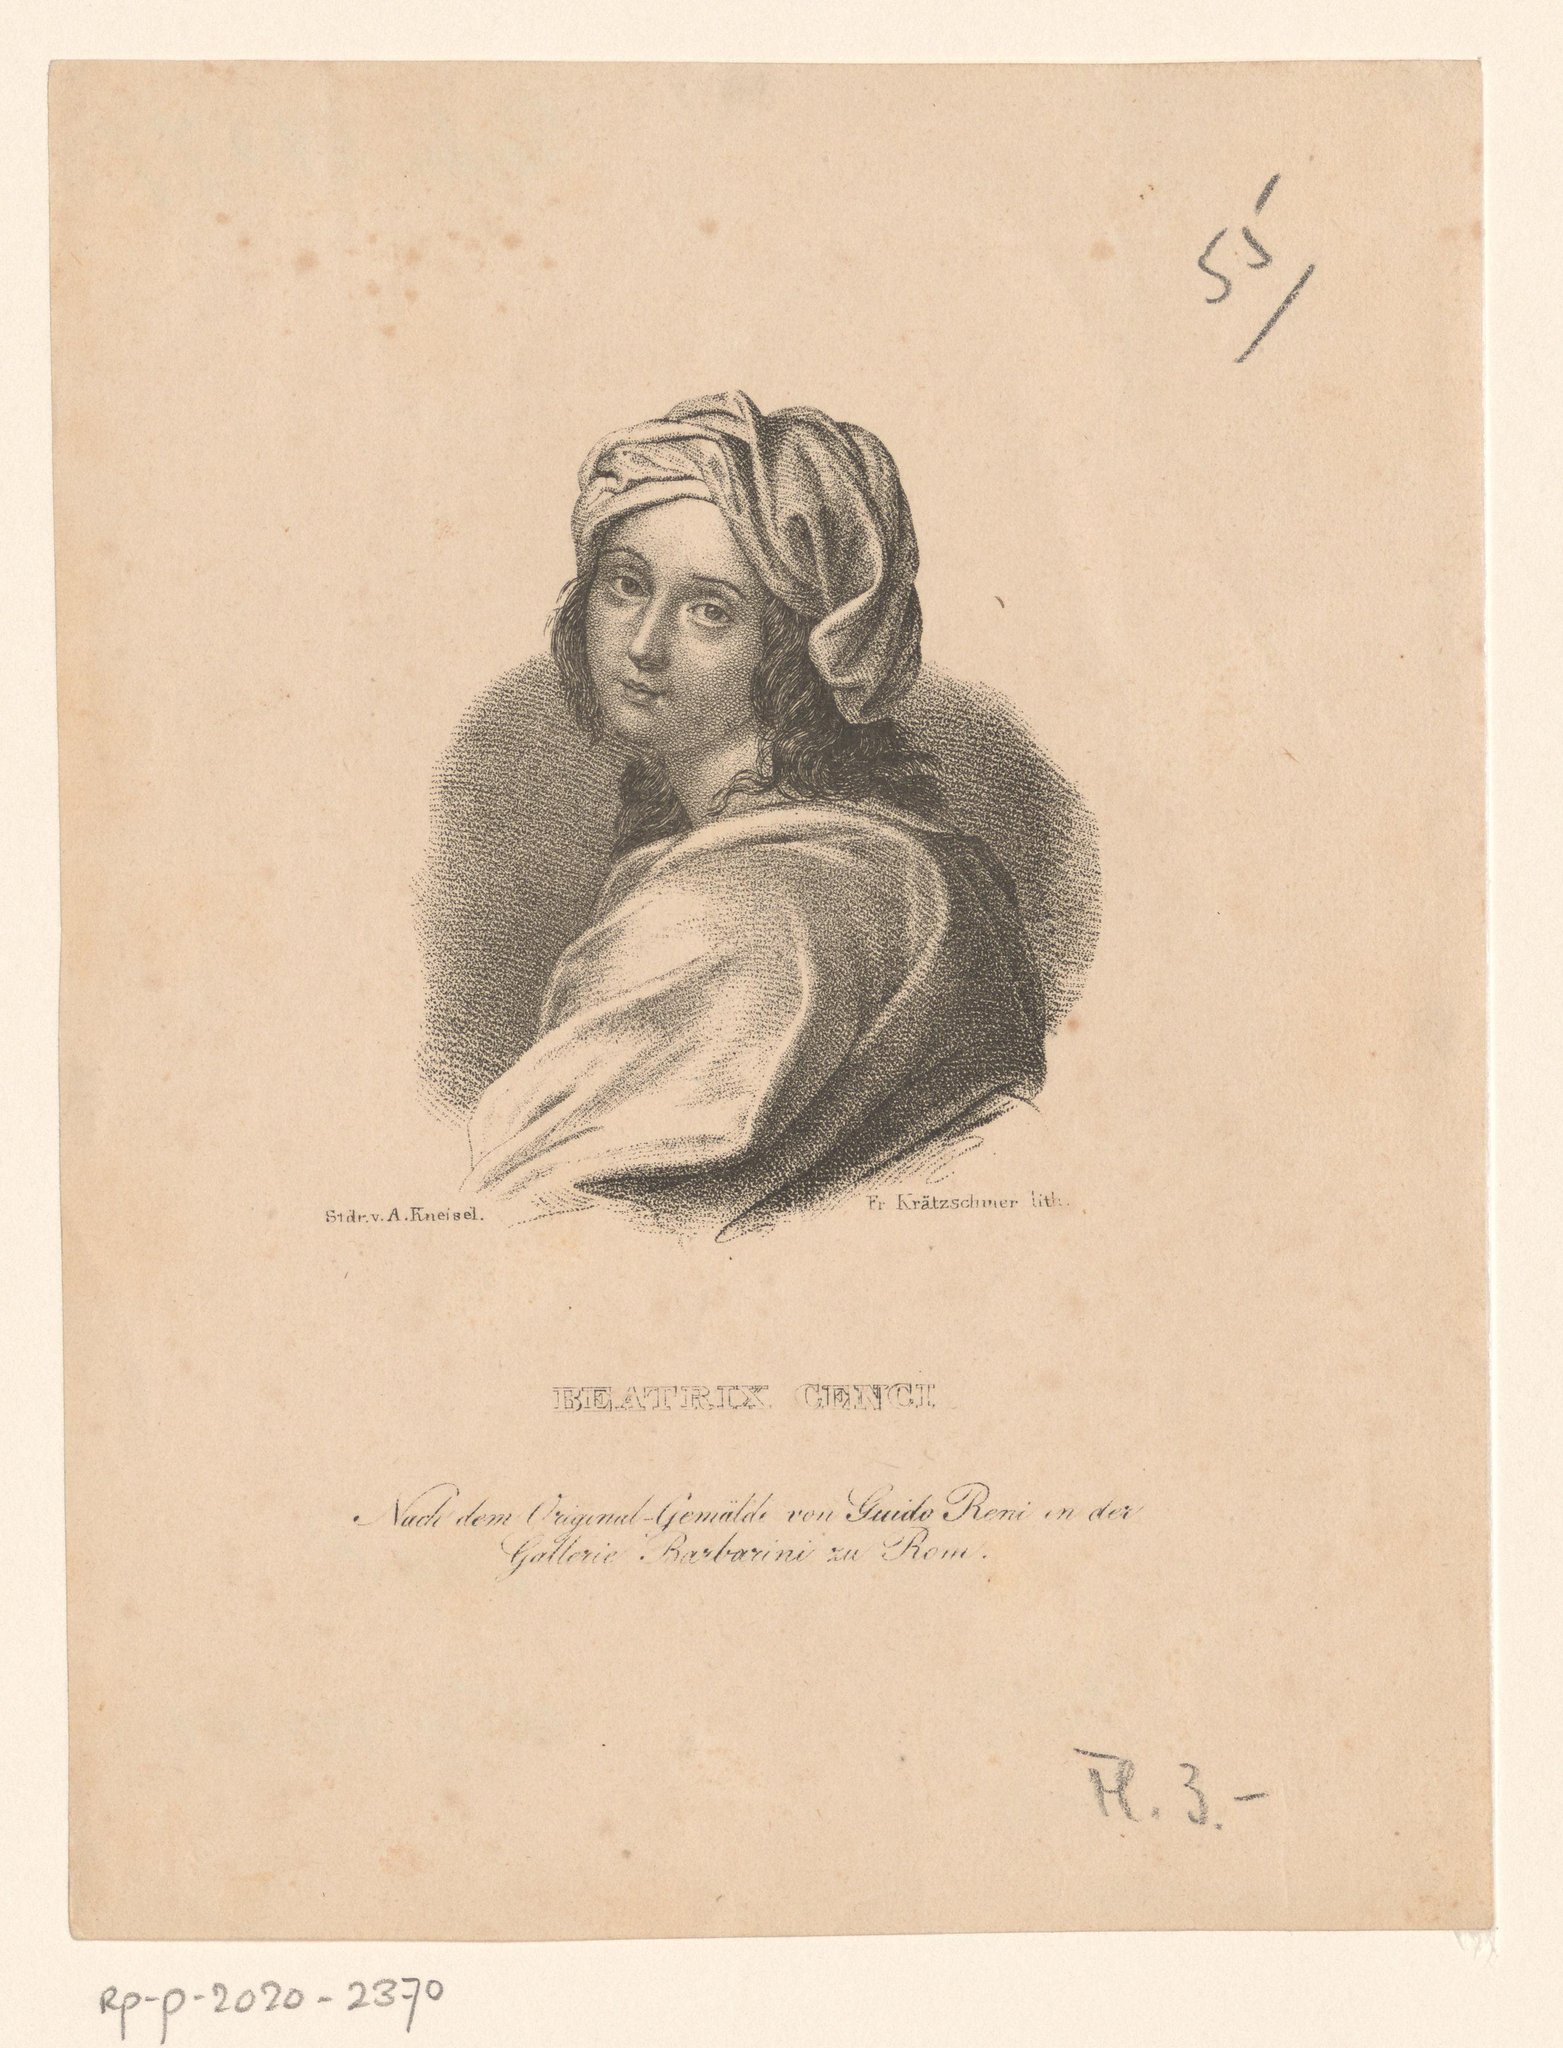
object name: print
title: Portret van Beatrice Cenci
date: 1816-1855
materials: paper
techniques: lithograph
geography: leipzig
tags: historical persons